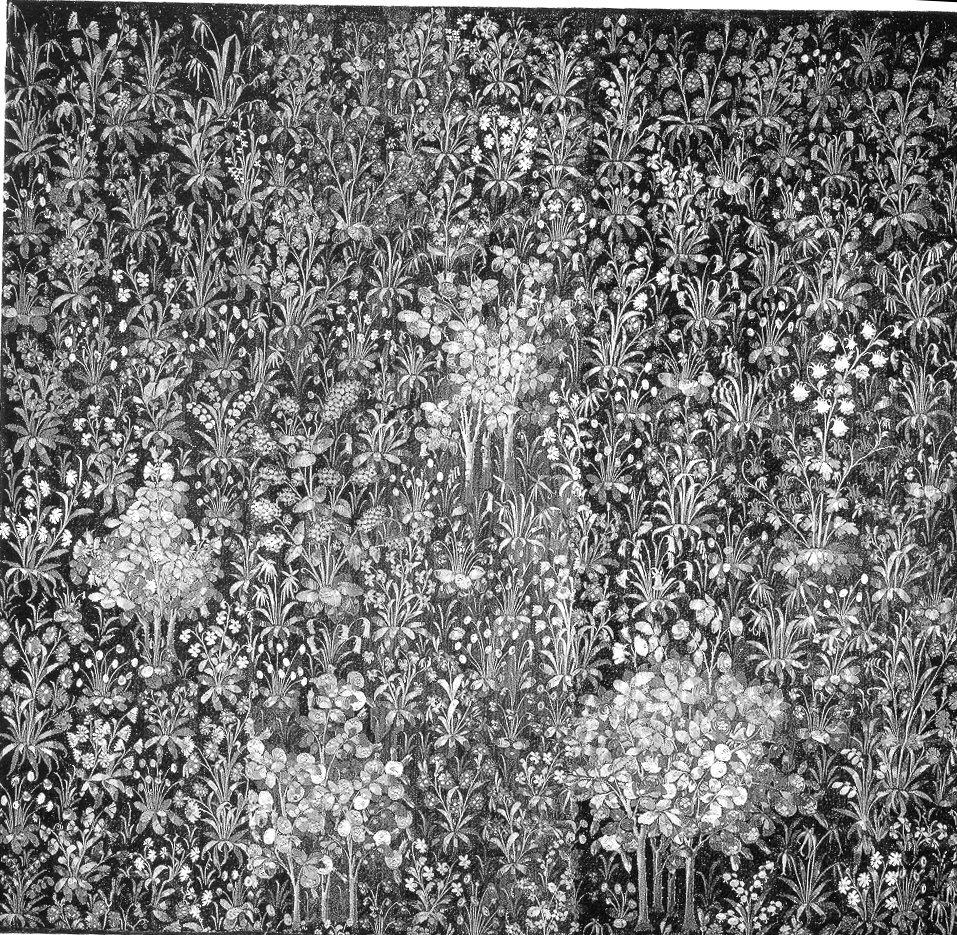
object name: tapestry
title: Flowering Plants and Rosebushes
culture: south netherlandish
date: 1500-1530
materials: wool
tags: flowers